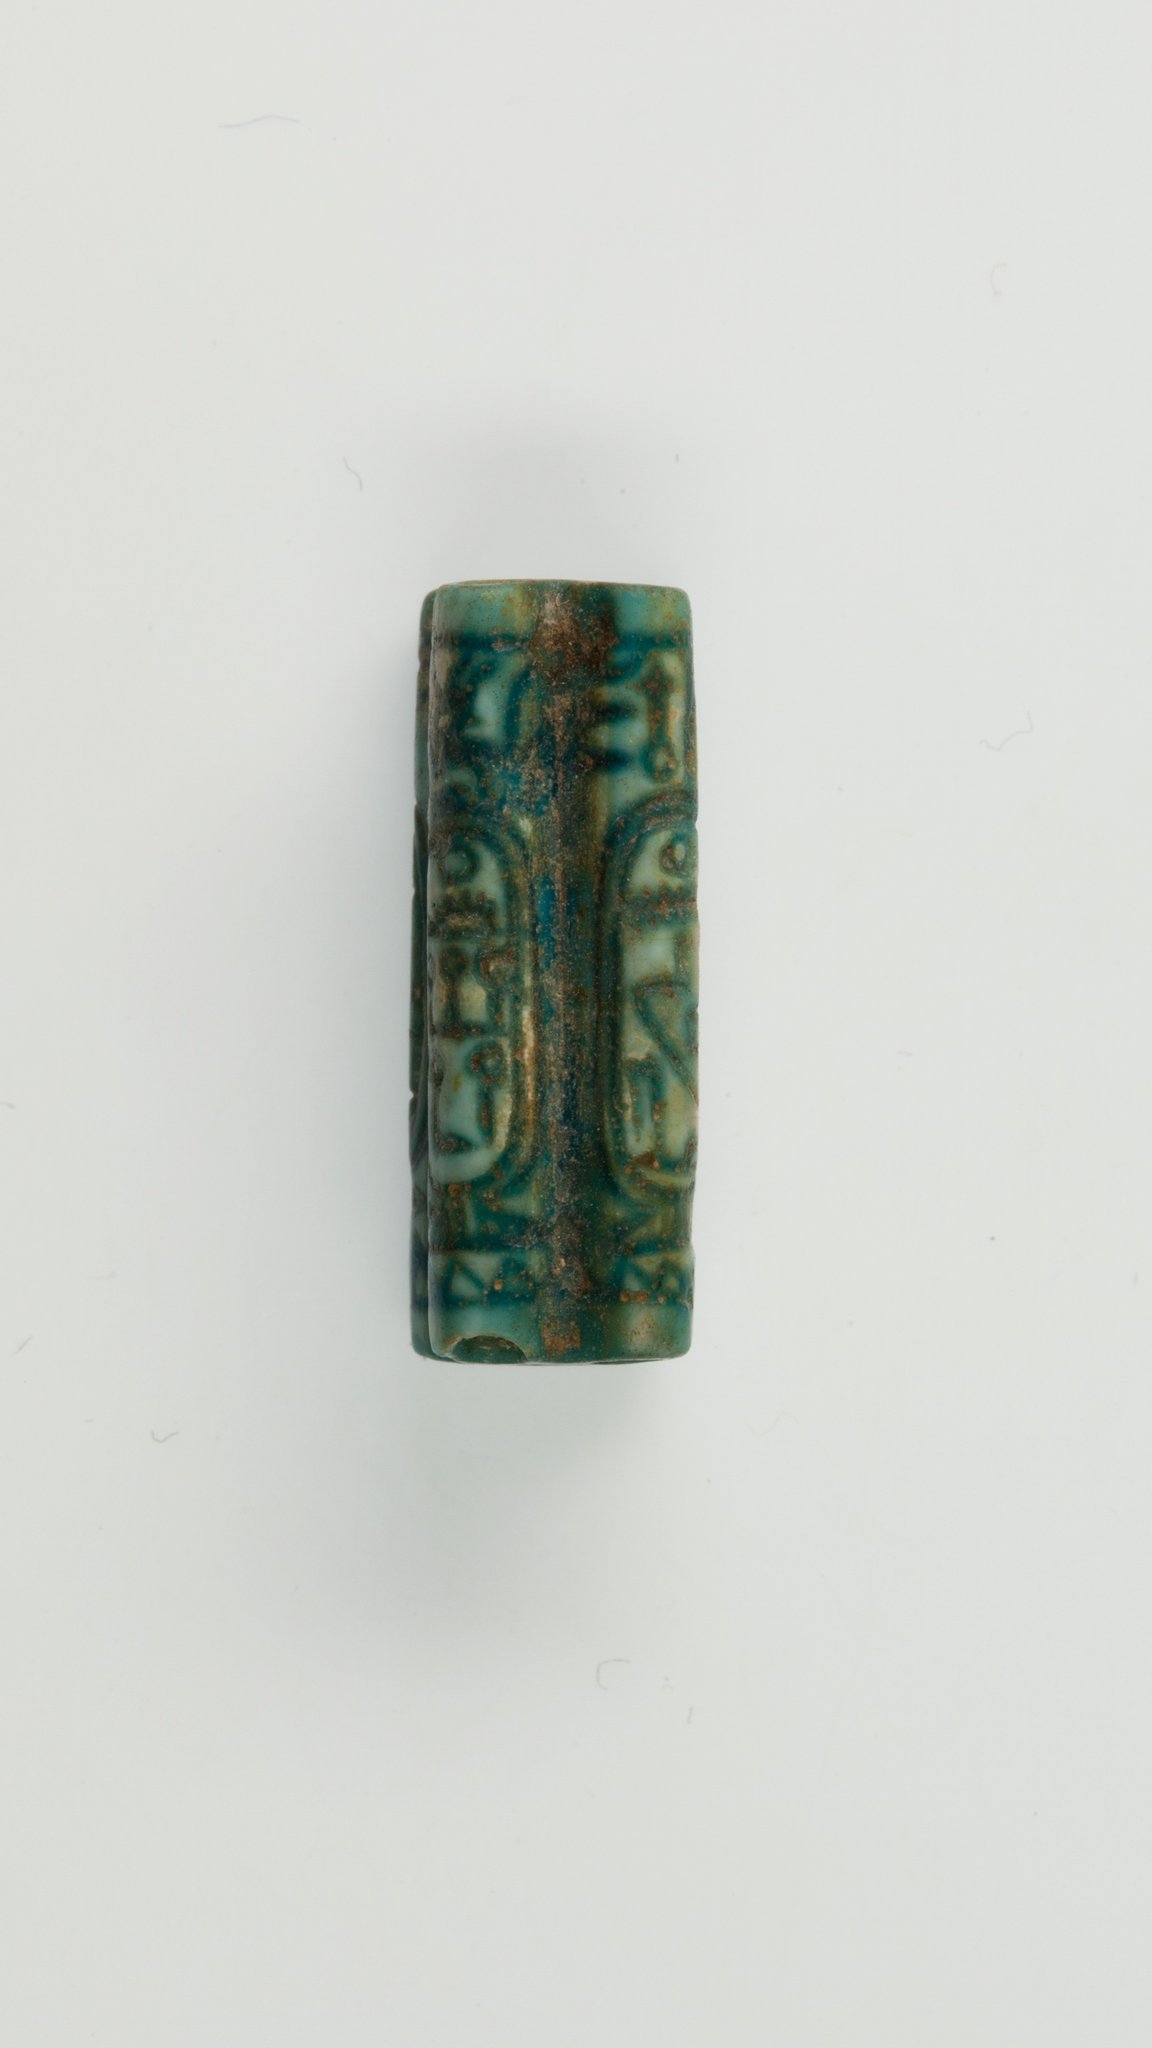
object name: cylinder bead group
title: Cylinder bead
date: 1950-1804 BCE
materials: stone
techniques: glazing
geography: egypt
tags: hieroglyphs